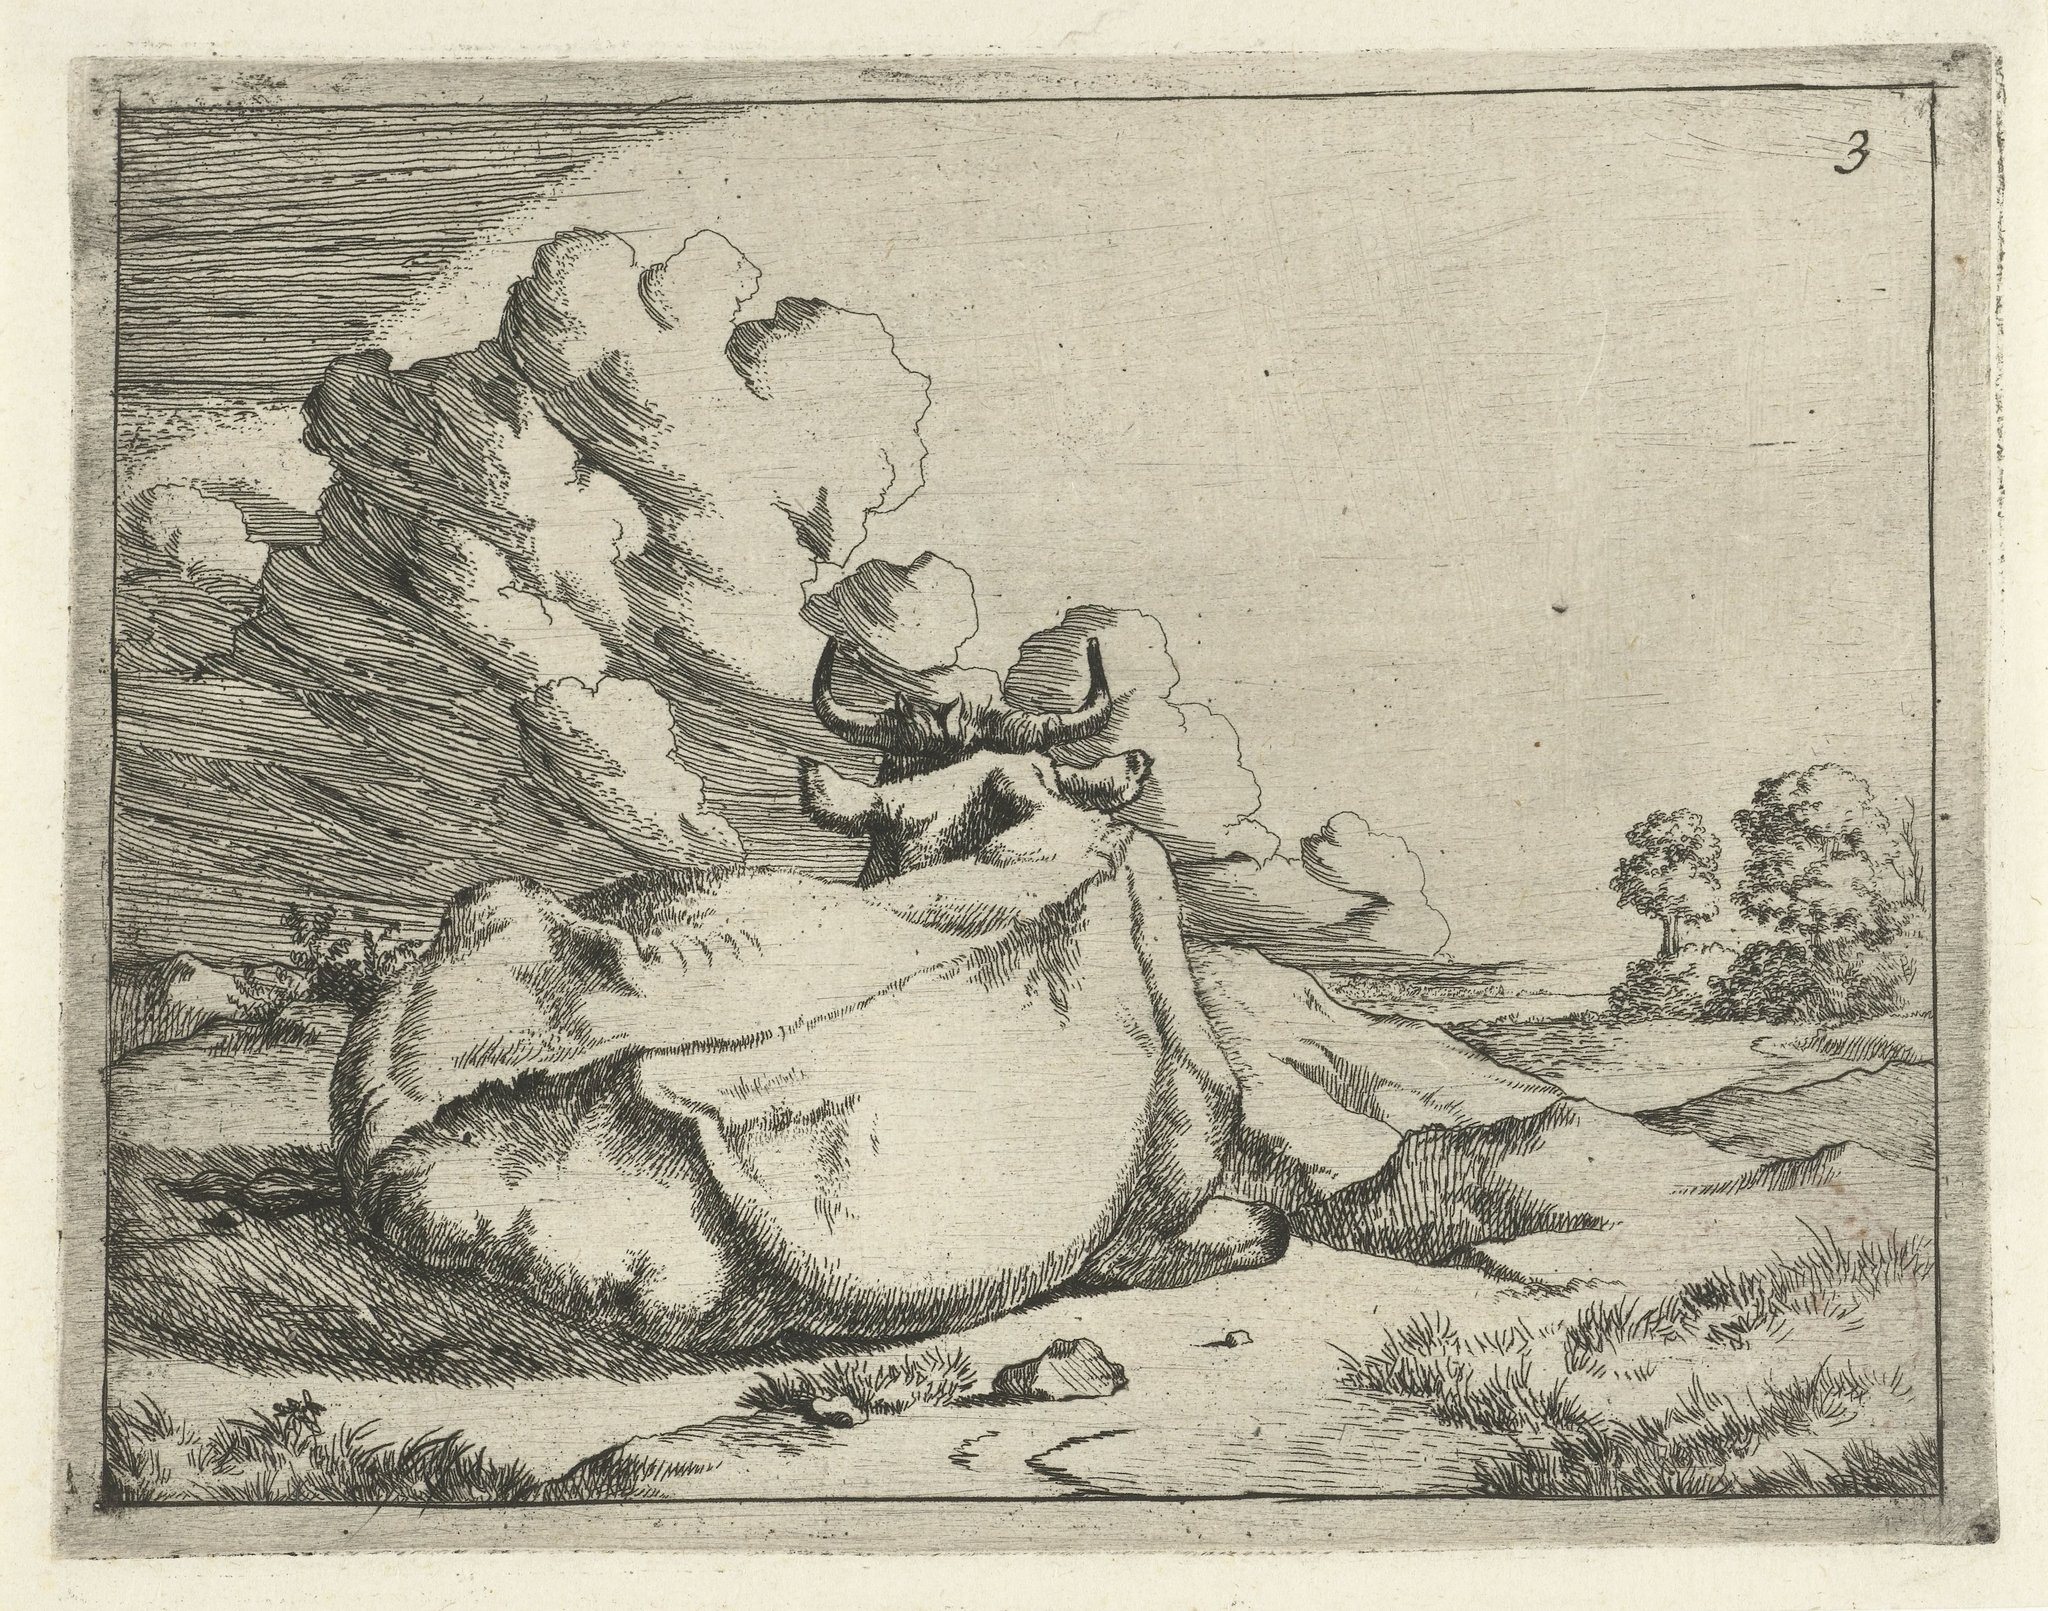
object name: print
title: Liggend rund, op de rug gezien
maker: marcus de bye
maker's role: print maker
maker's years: 1639-1688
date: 1657-1677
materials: paper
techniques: etching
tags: cow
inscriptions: collector's mark: Lugt 240